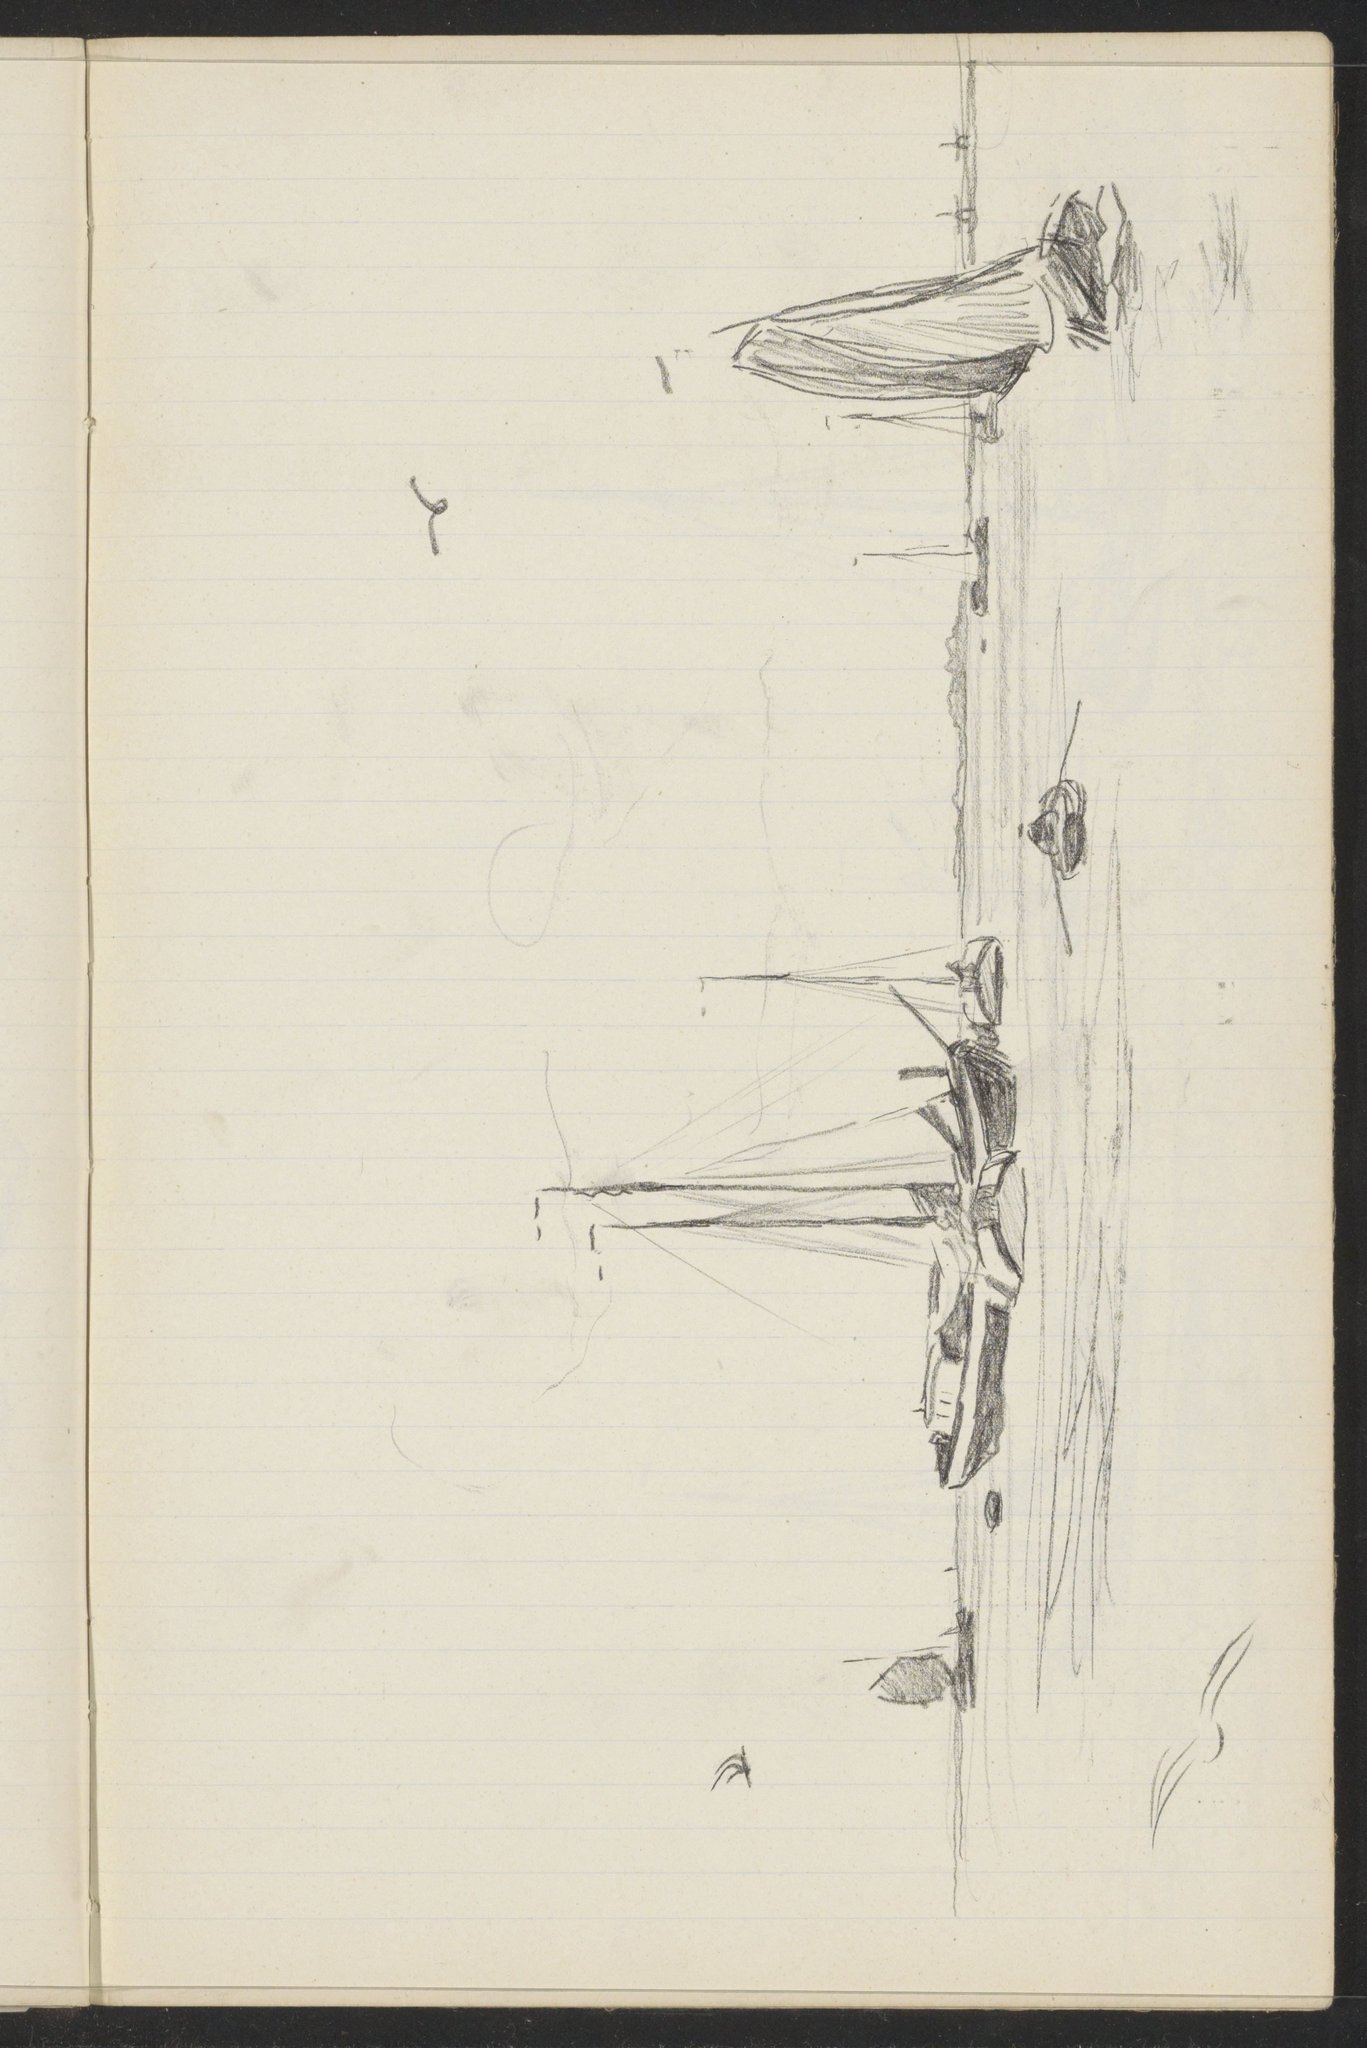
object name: sketchbook leaf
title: Zeil- en roeiboten op open water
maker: willem bastiaan tholen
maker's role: draughtsman, painter, print maker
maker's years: 1860-1931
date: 1900-1931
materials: chalk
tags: city-view, and landscape with man-made constructions, sailing-ship, sailing-boat, landscapes with waters, waterscapes, seascapes (in the temperate zone), rowing-boat, canoe, etc.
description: Op de achtergrond een landschap met molens. Blad 51 recto uit een schetsboek met 55 bladen.